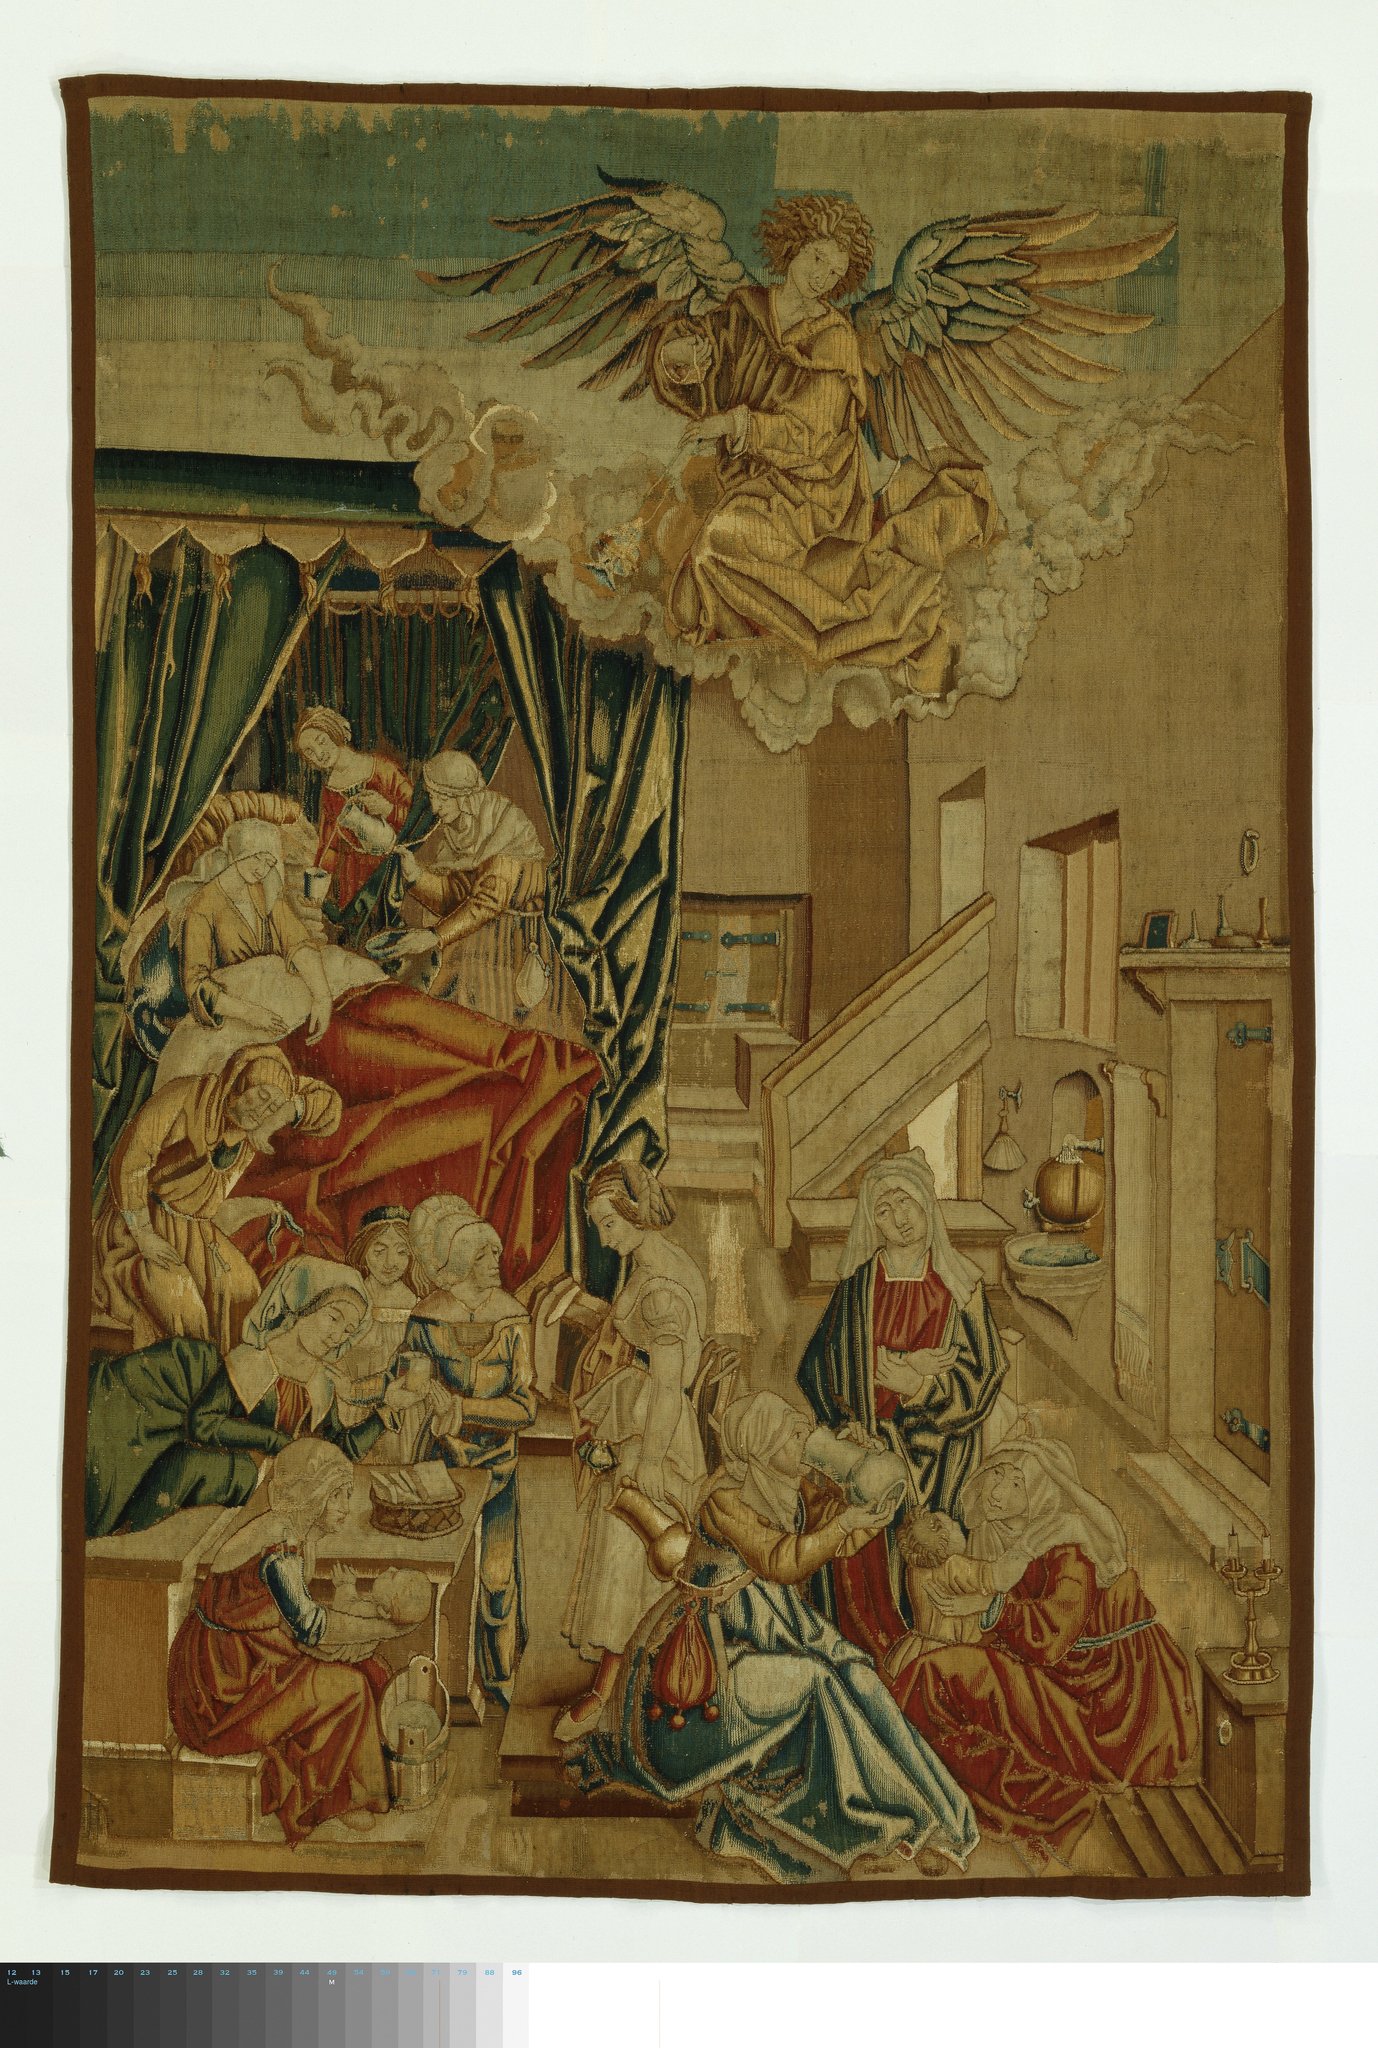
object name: tapestry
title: De geboorte van de maagd Maria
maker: Anonymous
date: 1530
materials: silk, wool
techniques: tapestry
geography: germany